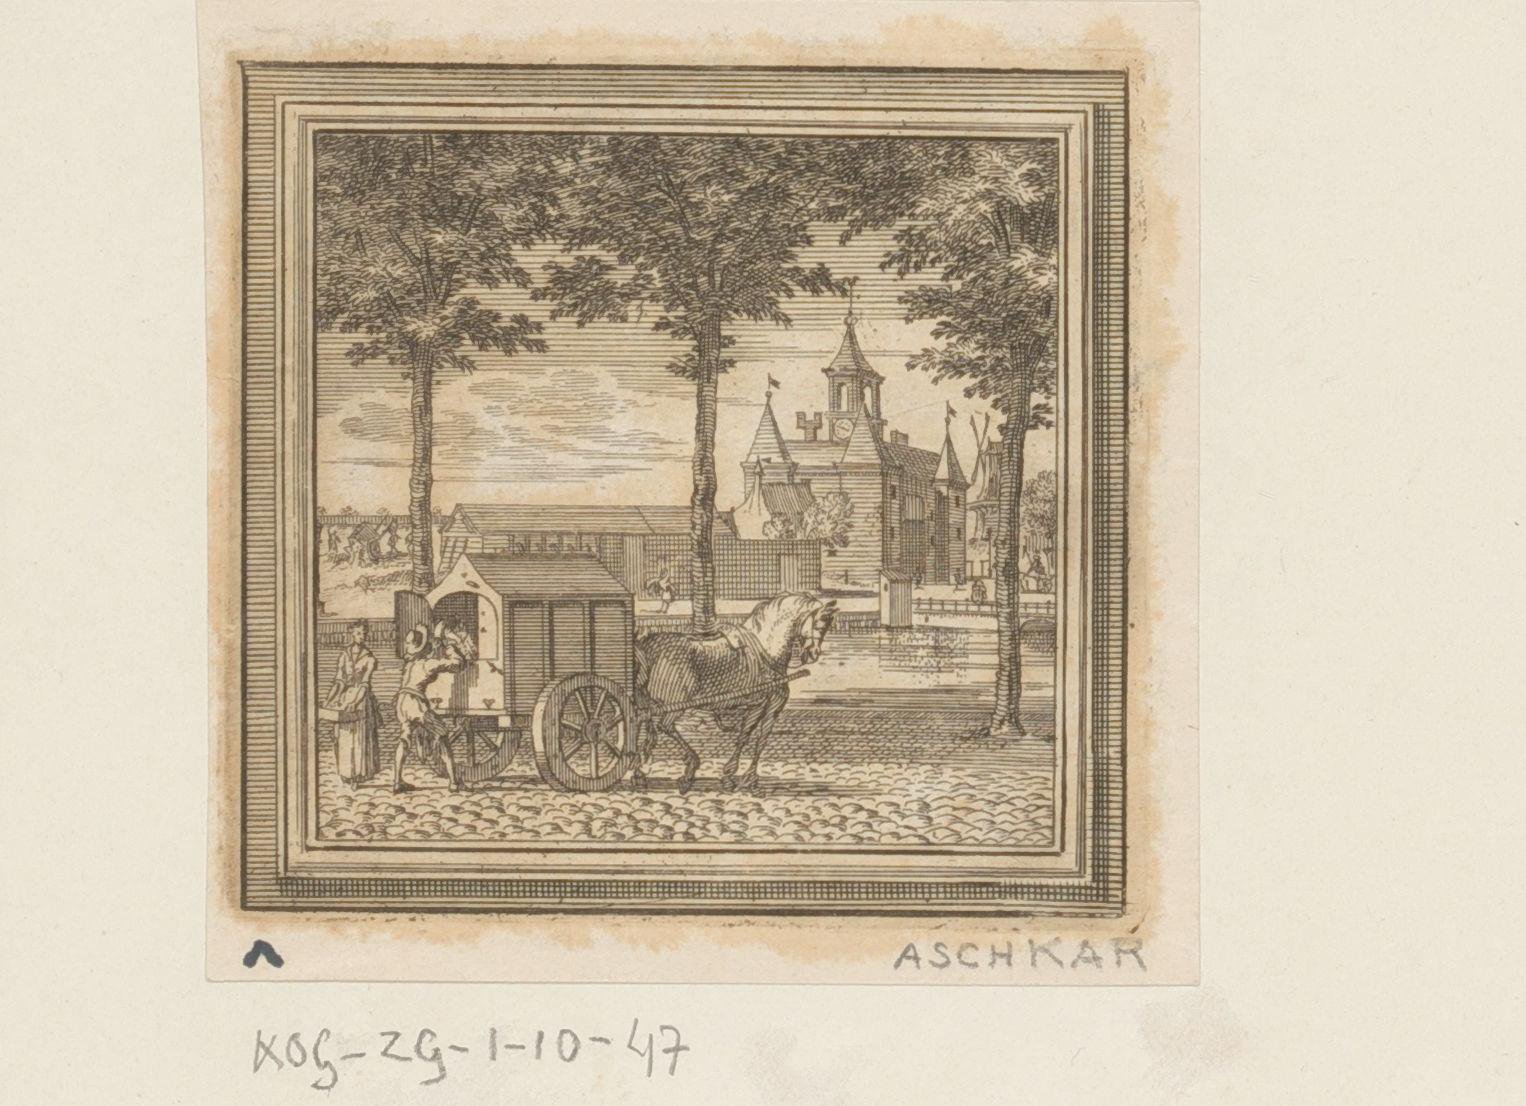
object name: print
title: Aschkar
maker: Anonymous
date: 1700-1799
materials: paper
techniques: engraving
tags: garbage collecting lorry, garbage truck, animal traction, animal-drawn vehicle (carriage etc.)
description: Aschkar, een ouderwetse vuilniswagen getrokken door een paard. Onderwerpsrubrieken binnen de Atlas Zeden en Gewoonten: Vervoermiddelen te land en te water, Vervoermiddelen te land, Reiskoetsen en post.